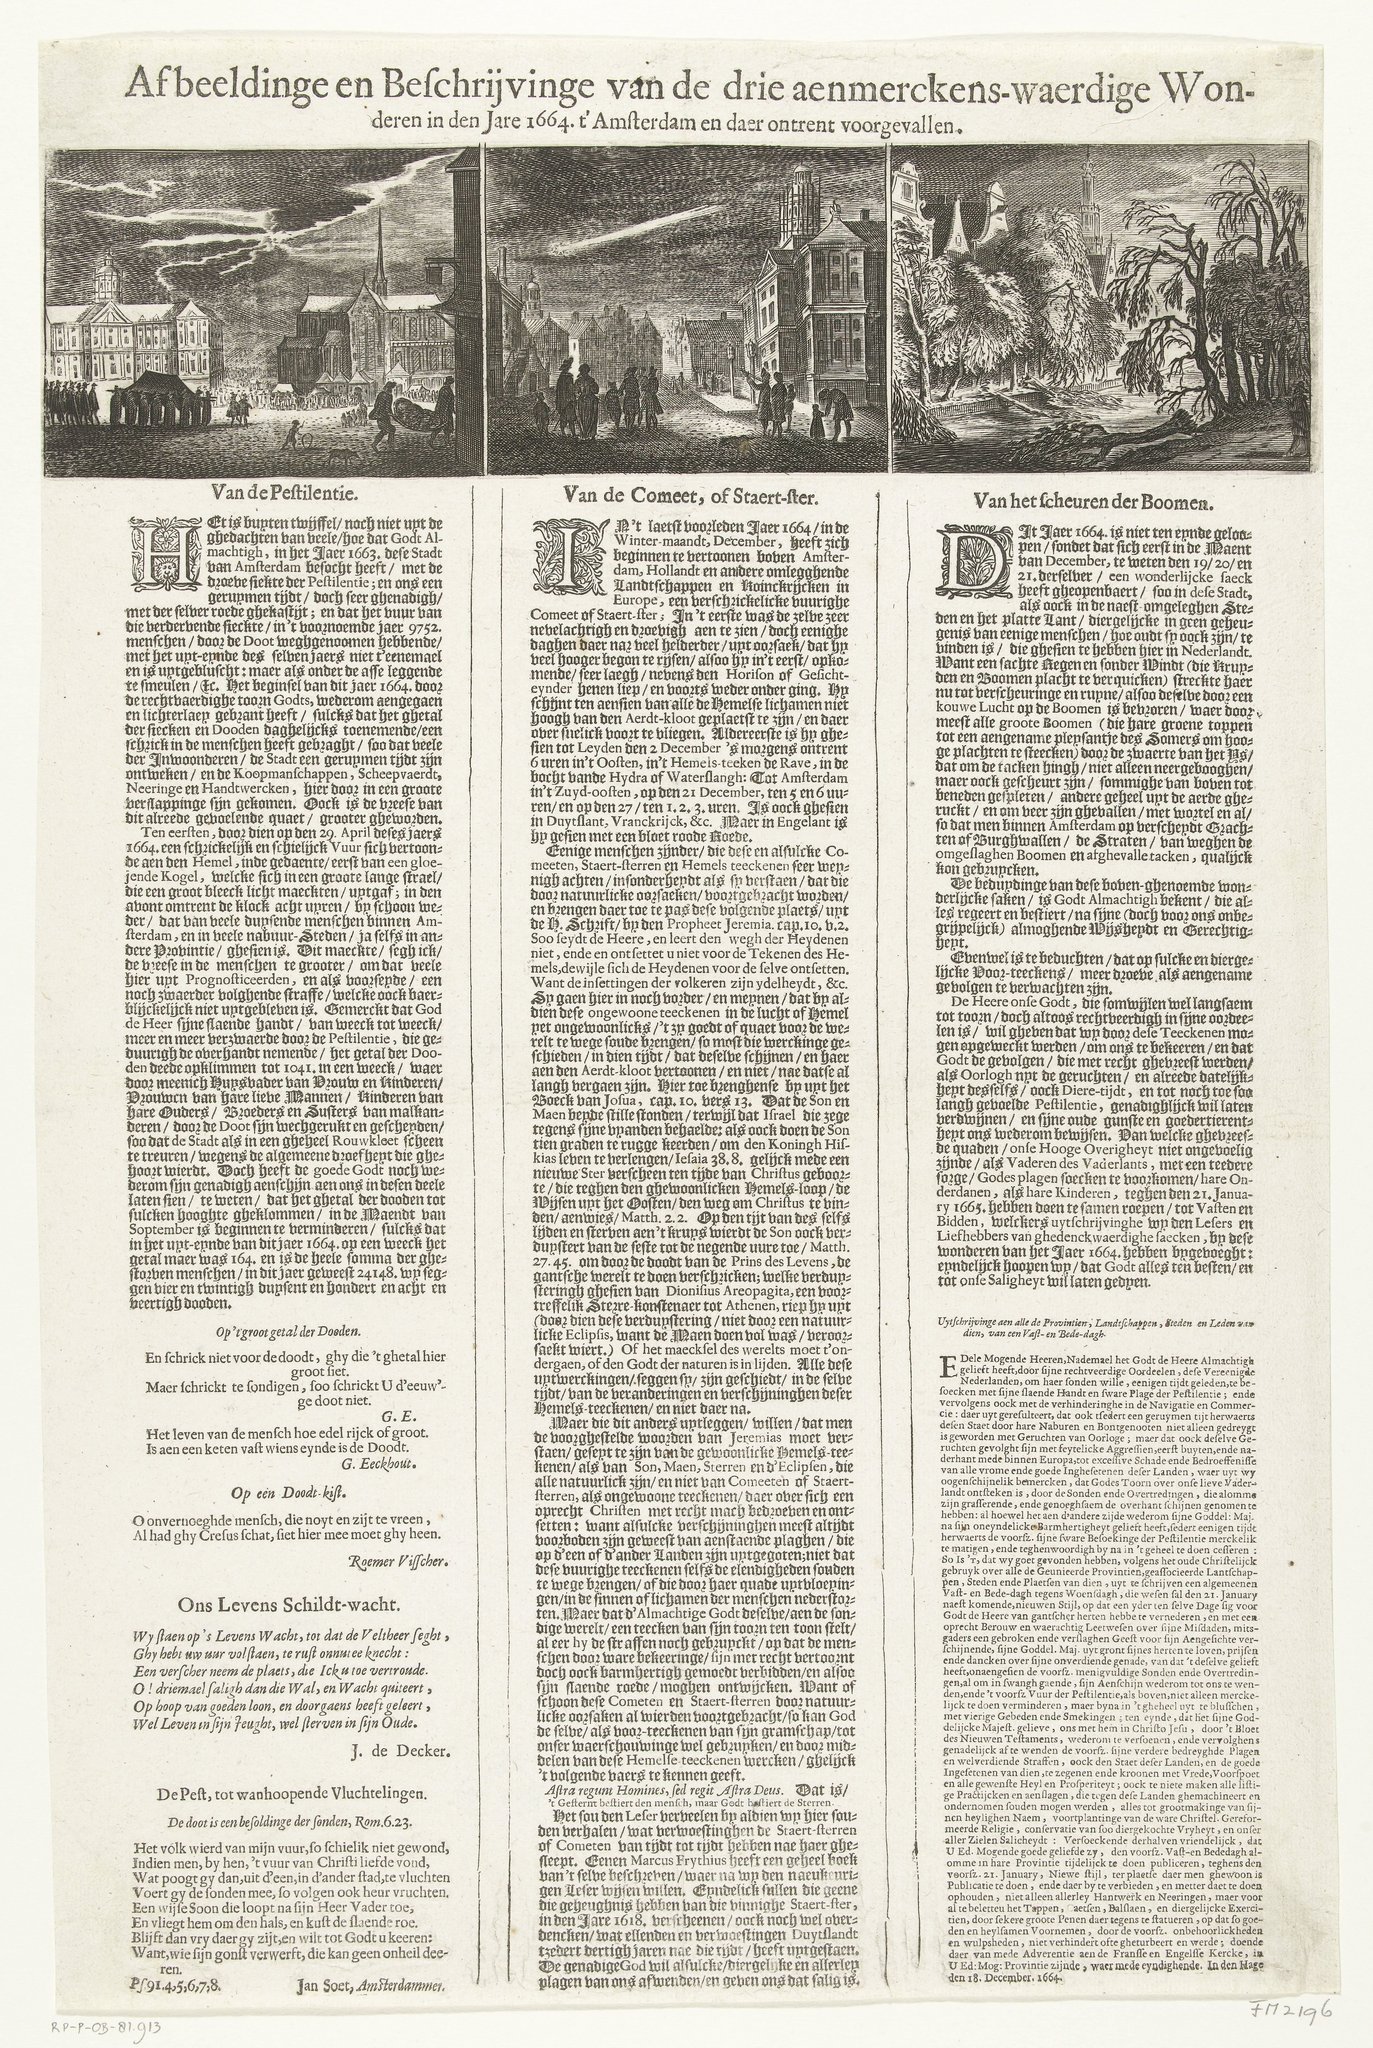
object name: print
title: Drie opmerkelijke gebeurtenissen te Amsterdam in het jaar 1664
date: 1664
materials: paper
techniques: engraving, letterpress printing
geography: amsterdam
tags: burial, consequences of weather, e.g. after the drought, before the storm, after the cyclone, comet, storm on land, plague, amsterdam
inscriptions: date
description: Drie opmerkelijke gebeurtenissen te Amsterdam in het jaar 1664. Bovenaan een plaat met drie voorstellingen. Links een gezicht op de Dam met Paleis en Nieuwe Kerk met het begraven van de slachtoffers van de pest. Midden de komeet of staartster boven de stad gezien vanaf de Dam. Rechts afgebroken en omgewaaide bomen langs een gracht. Onder de platen zijn in 3 kolommen beschrijvingen van en verzen op de gebeurtenissen gedrukt.